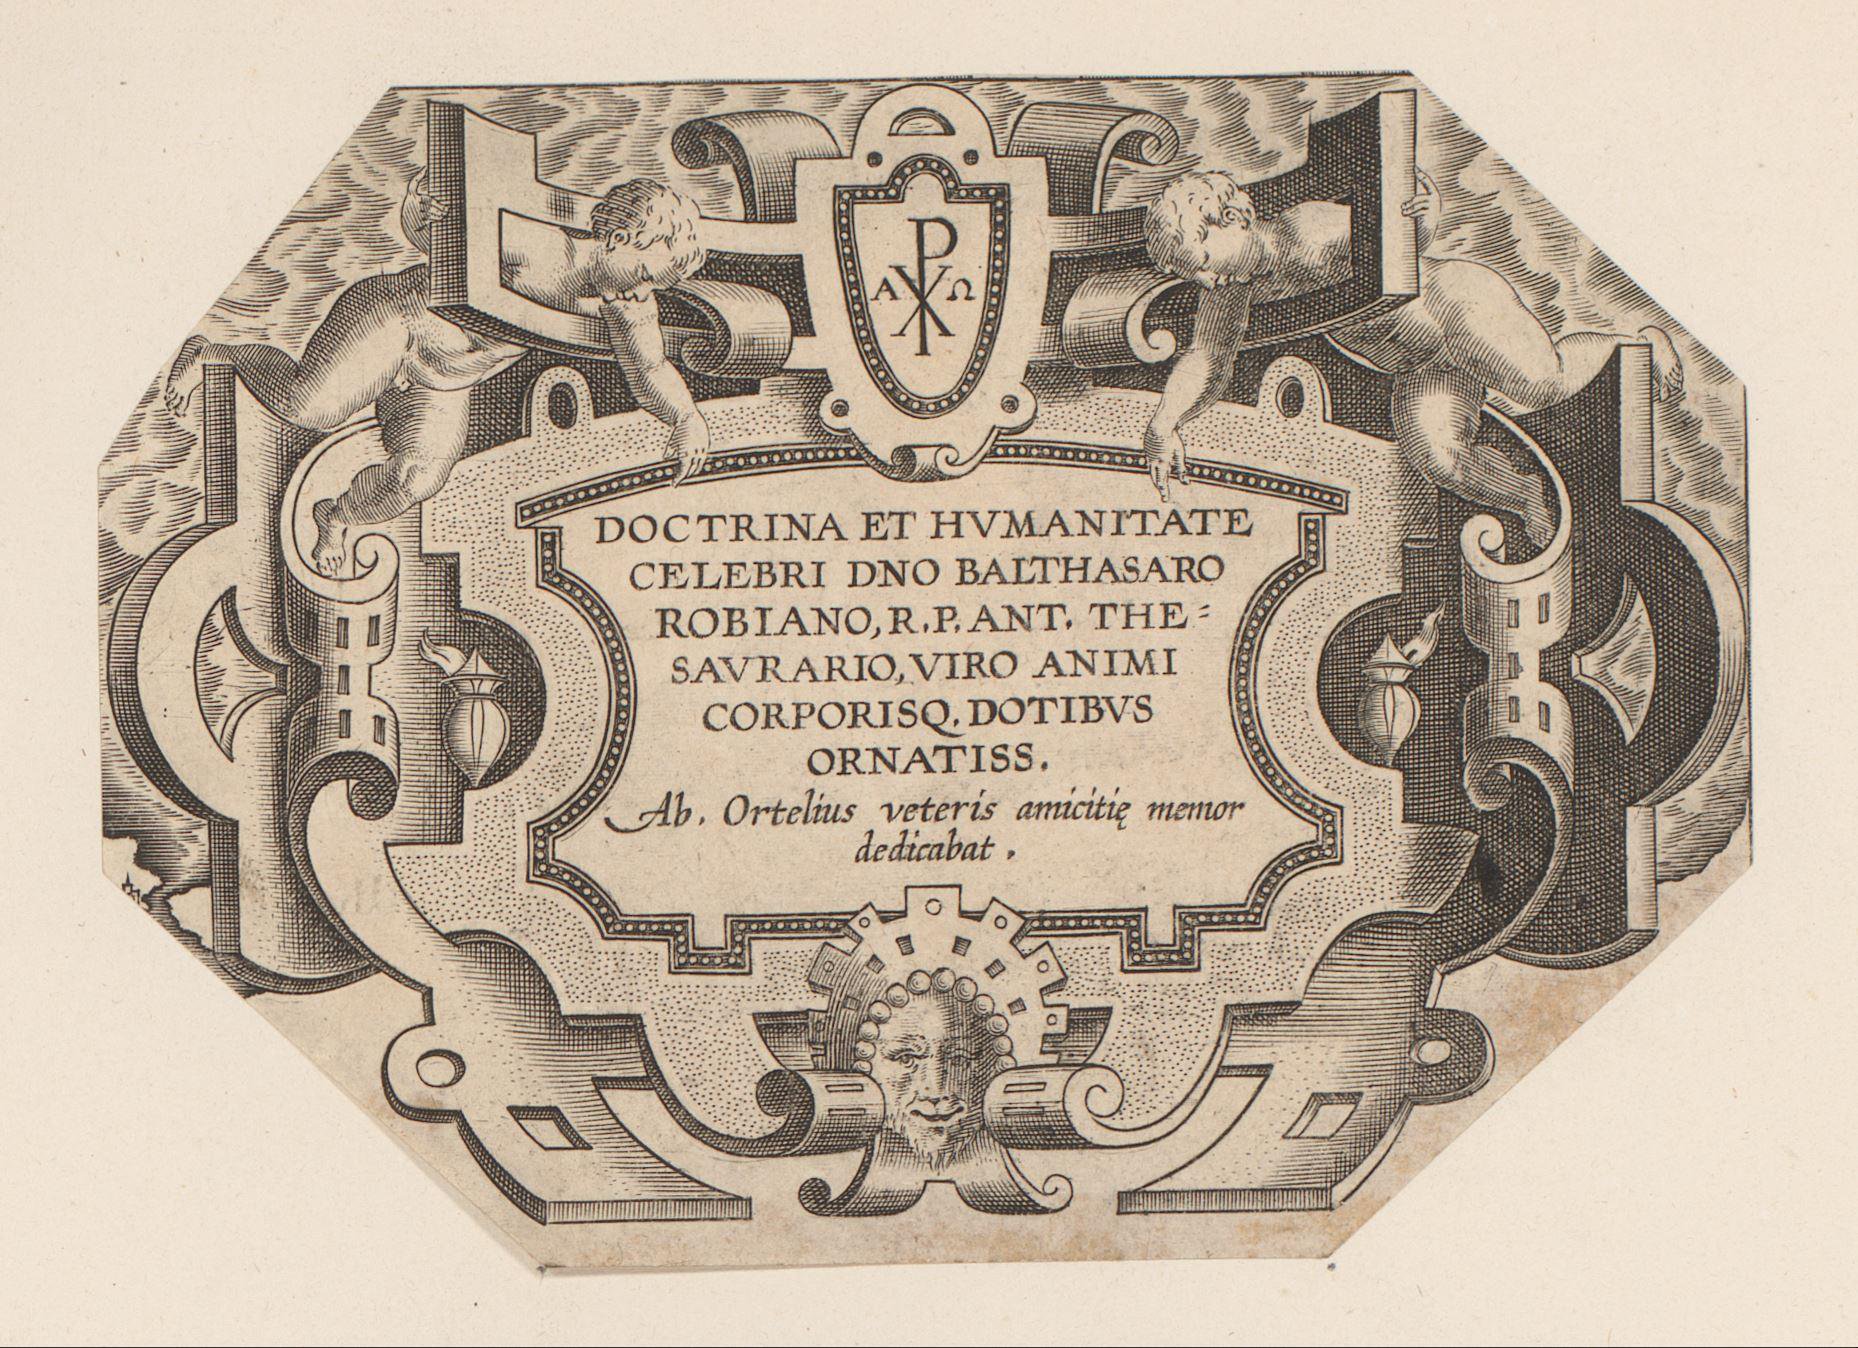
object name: print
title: Cartouche met Christusmonogram en twee putti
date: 1595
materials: paper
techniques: engraving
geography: antwerp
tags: ornament ~ cartouche, cupids: 'amores', 'amoretti', 'putti'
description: Cartouche met midden boven het Christusmonogram. Twee putti steken hun hoofd en een arm door het rolwerk. De cartouche is een fragment van een kaart over de zeereizen van Aeneas. De prent maakt deel uit van een album.